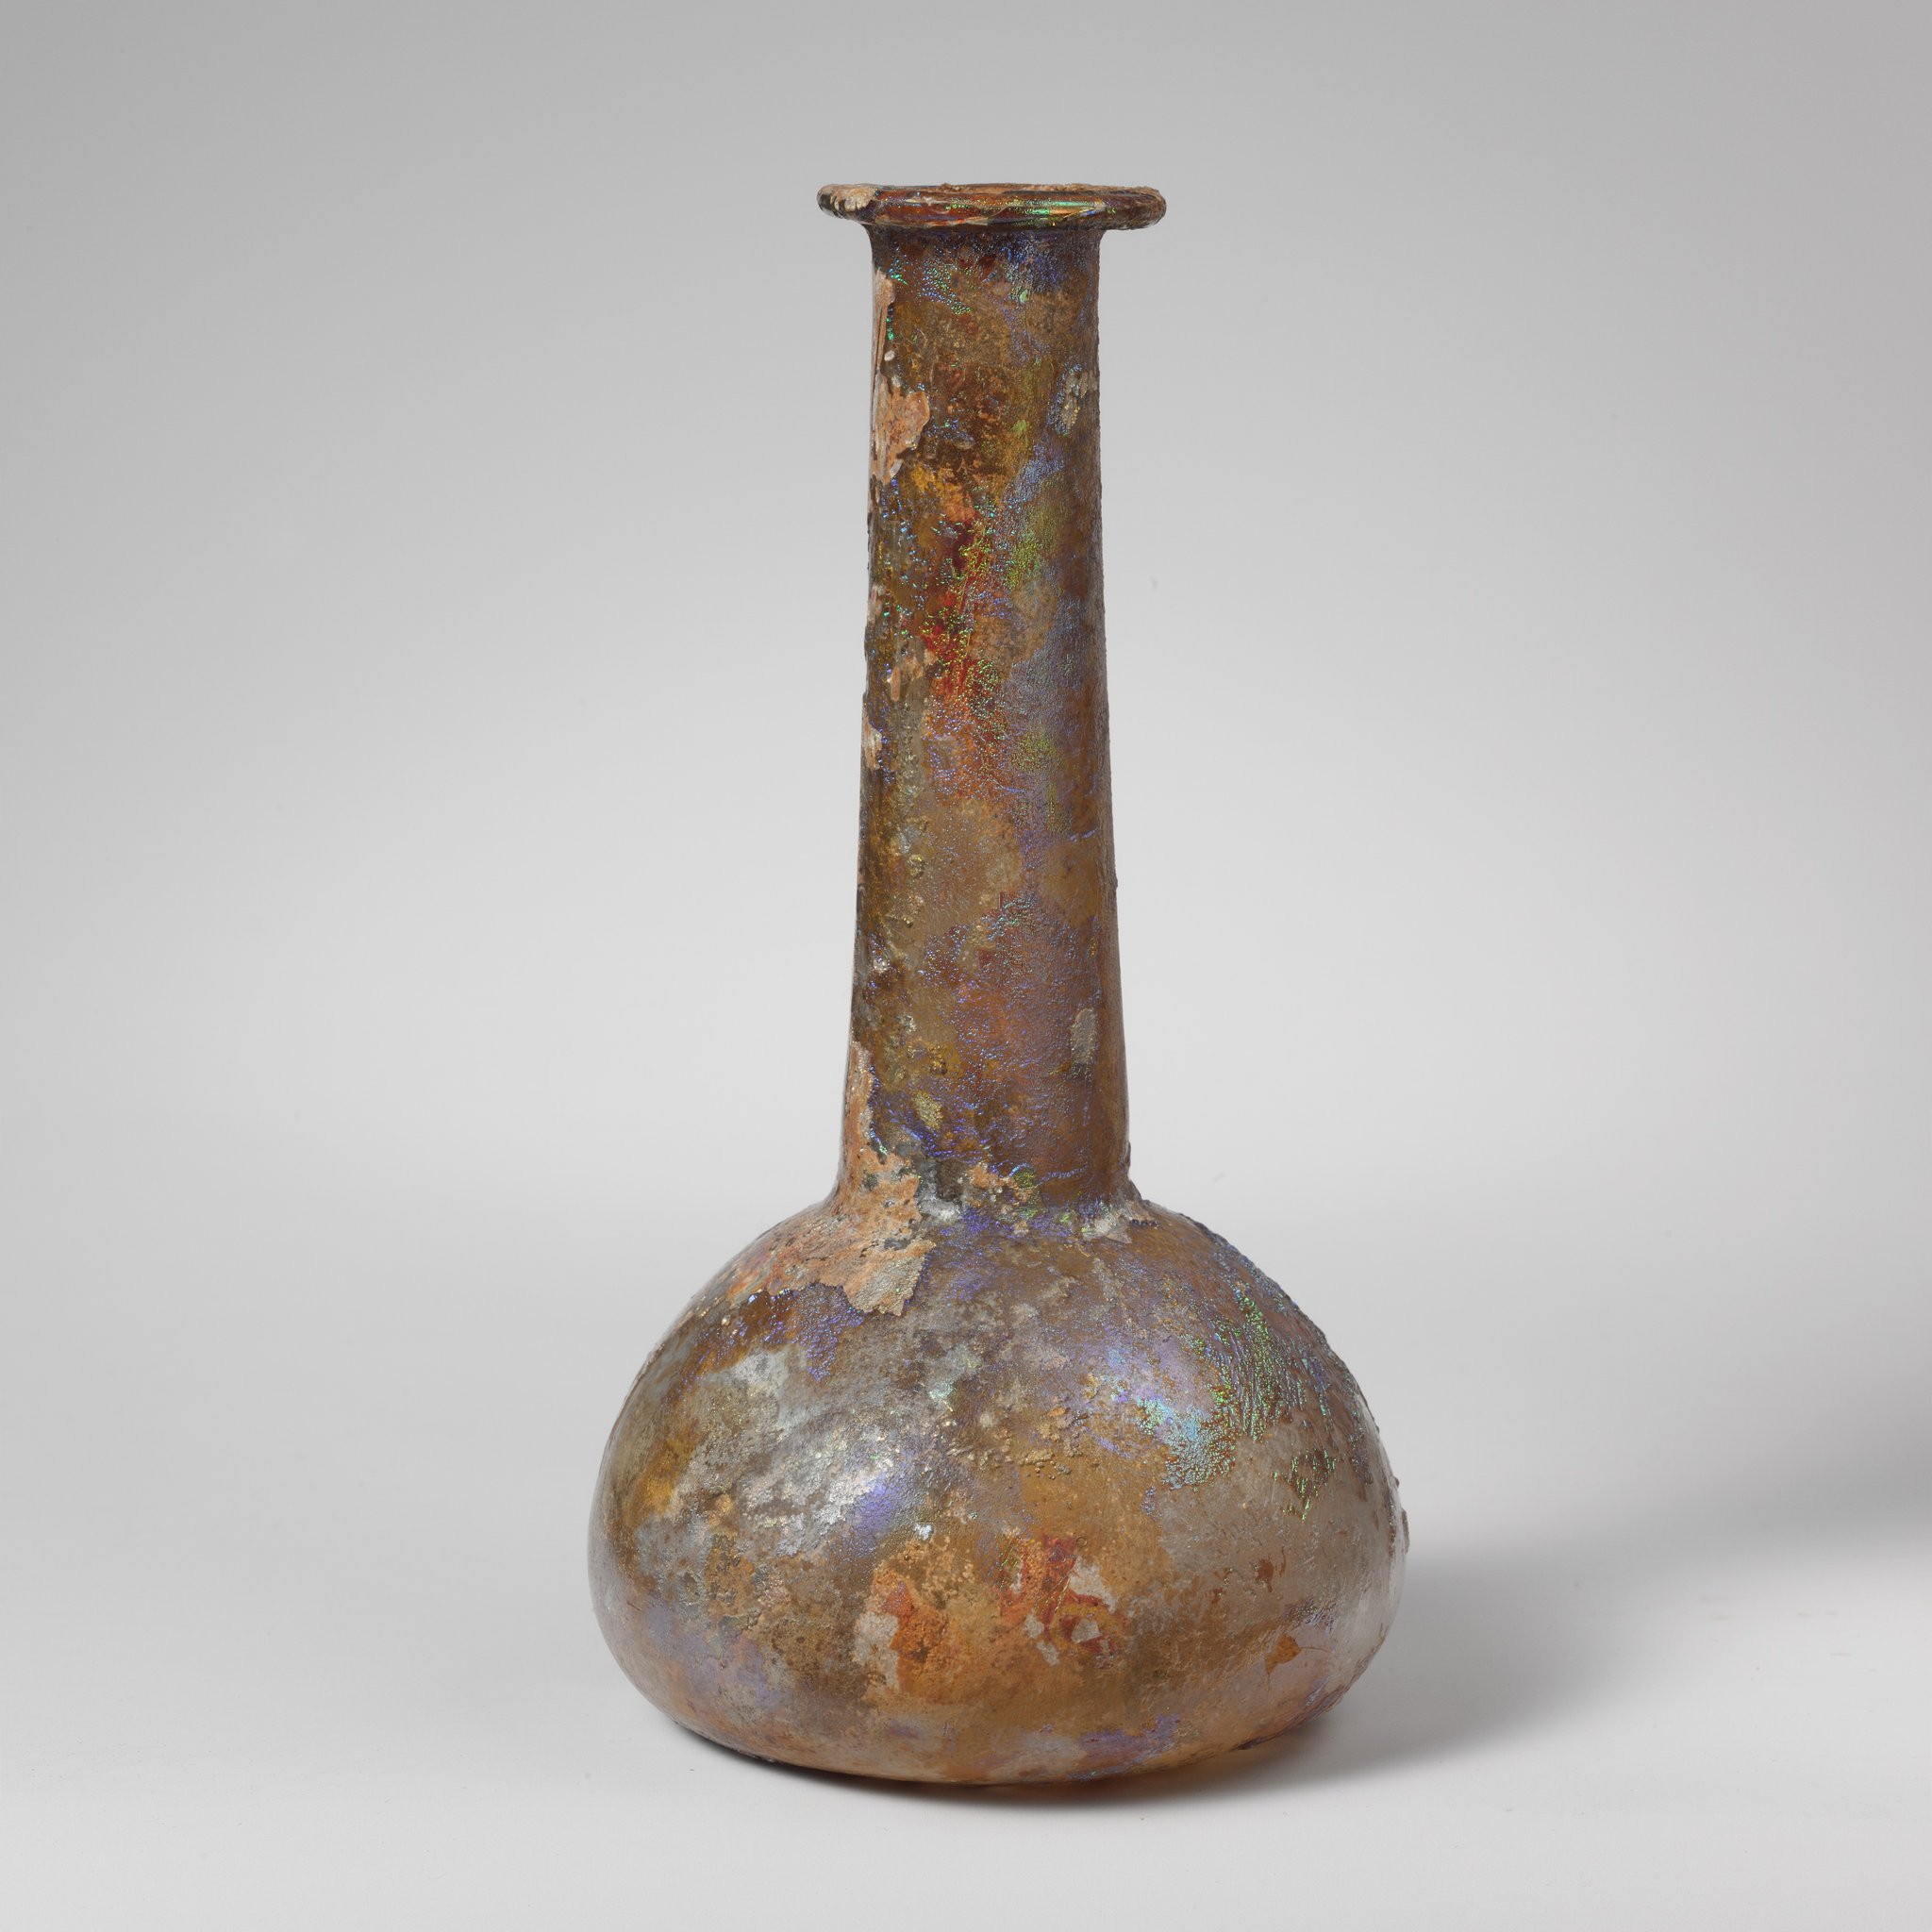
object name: perfume bottle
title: Glass perfume bottle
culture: roman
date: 101-300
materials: glass